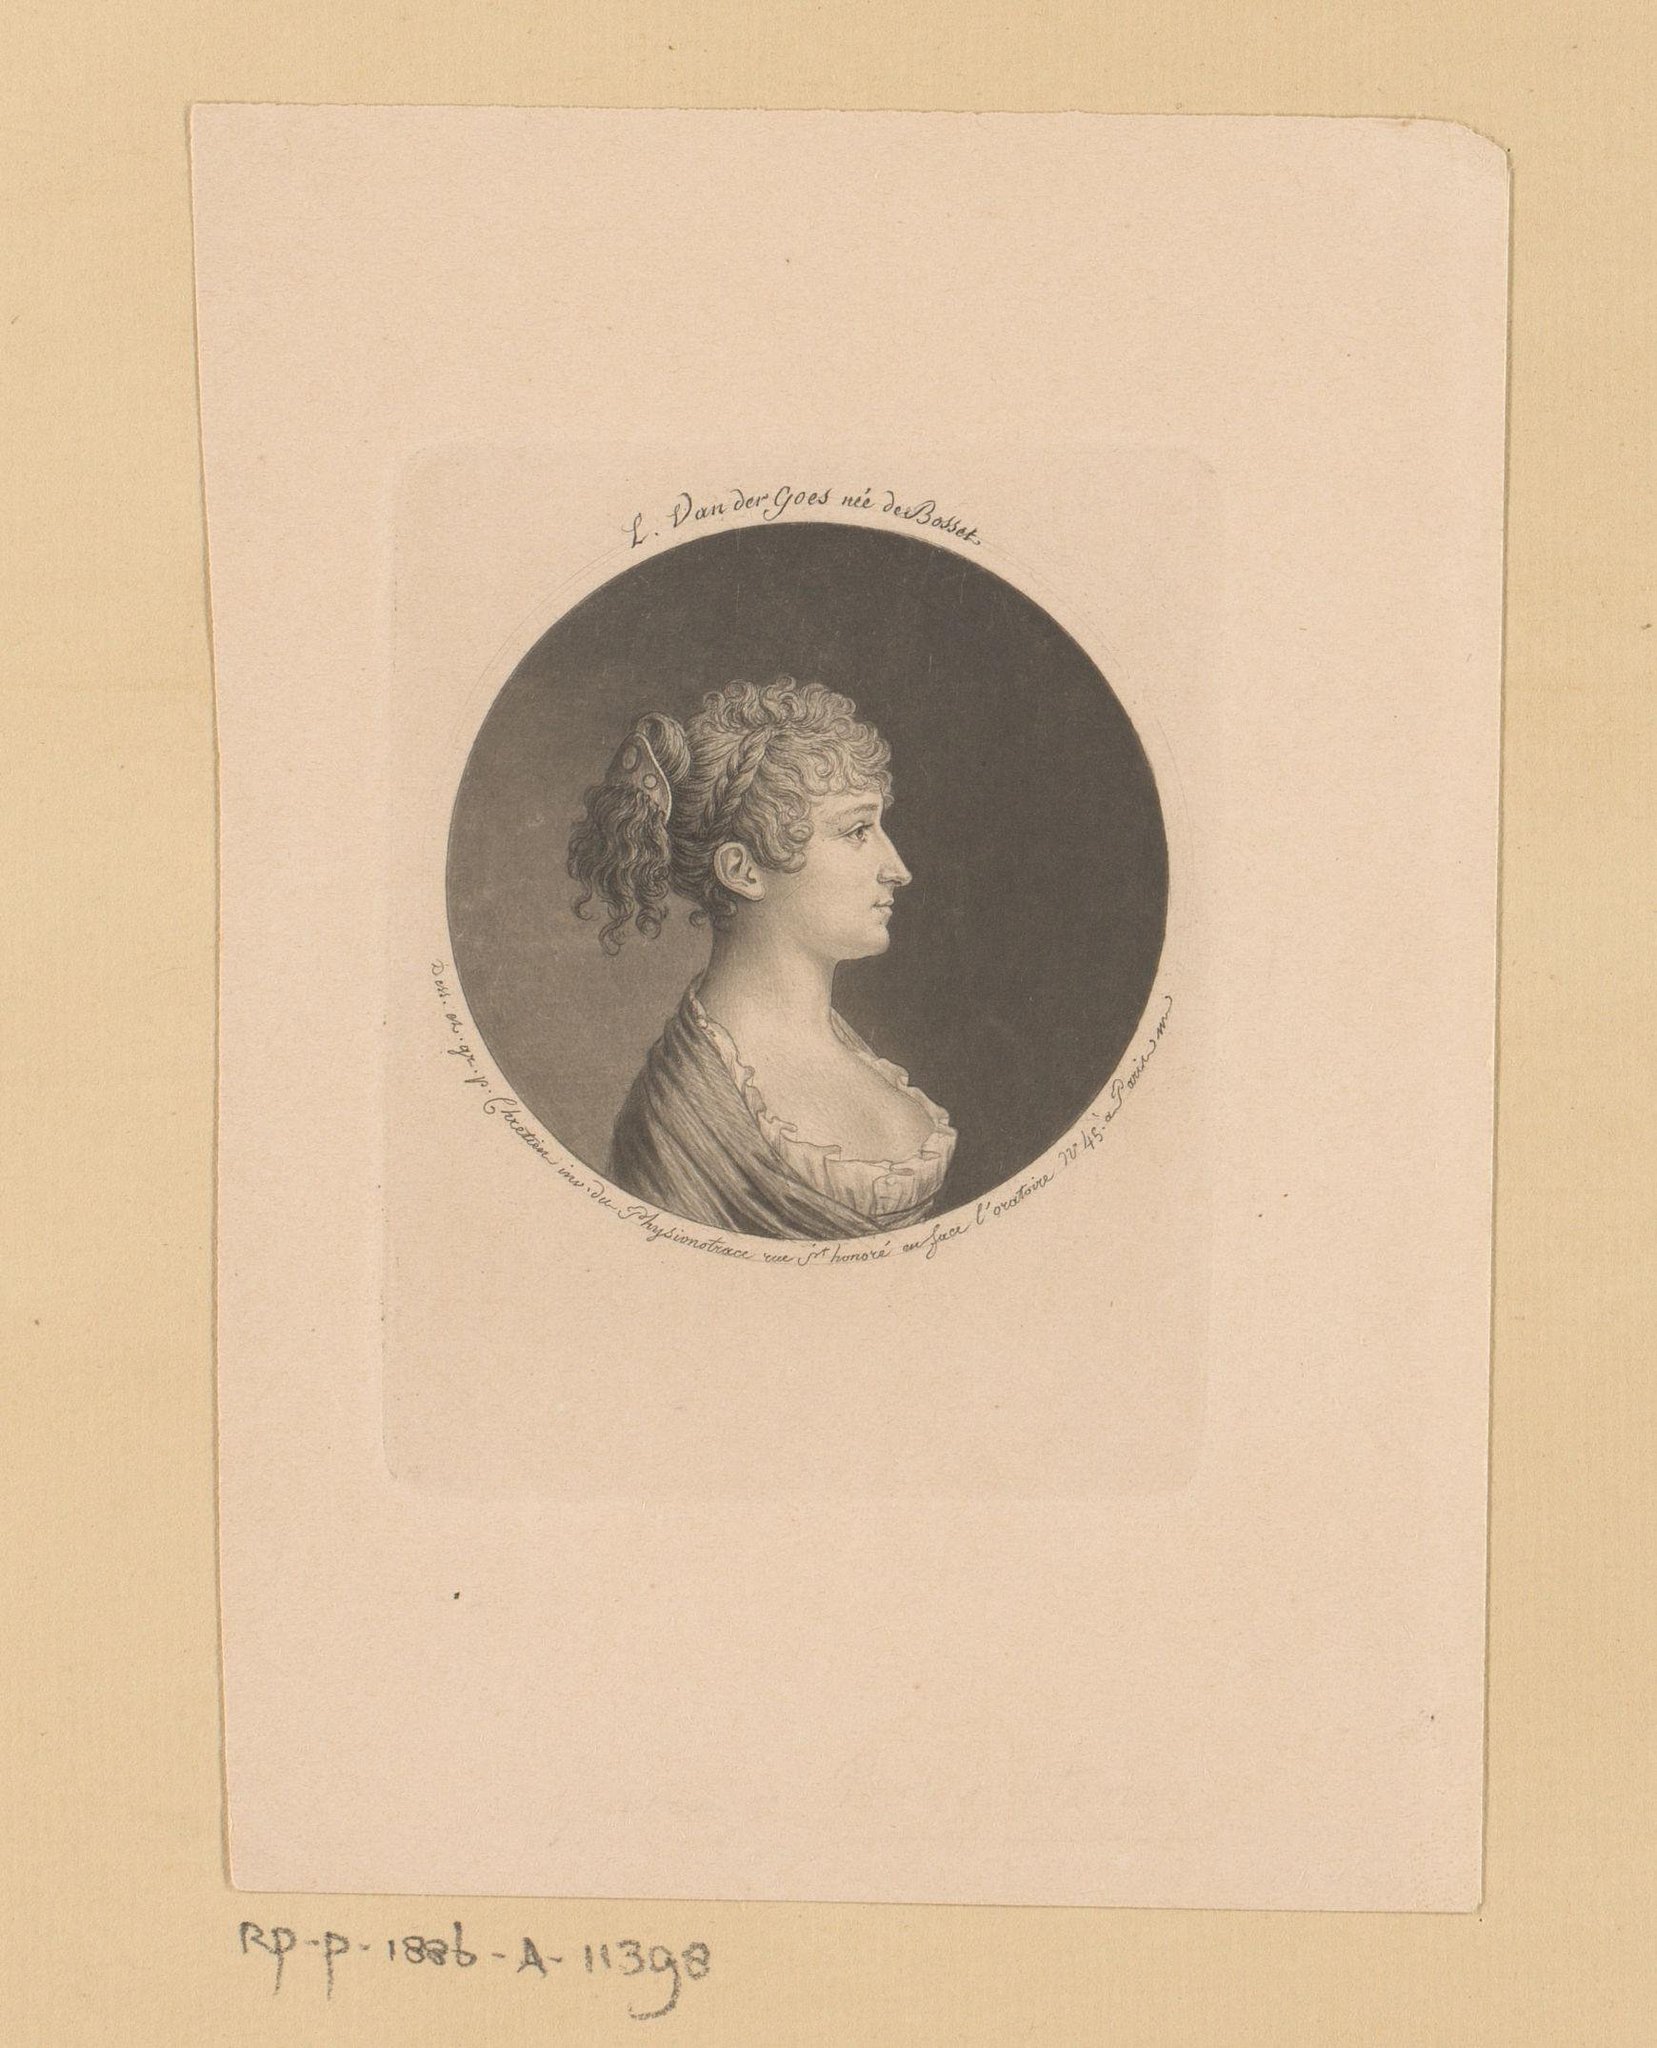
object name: print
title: L. van der Goes née de Bosset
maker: gilles louis chrétien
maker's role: print maker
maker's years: 1754-1811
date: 1785-1811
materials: paper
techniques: aquatint, etching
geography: paris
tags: silhouette-apparatus, 'physionotrace', historical persons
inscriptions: collector's mark: Lugt 2227, collector's mark: Lugt 2228